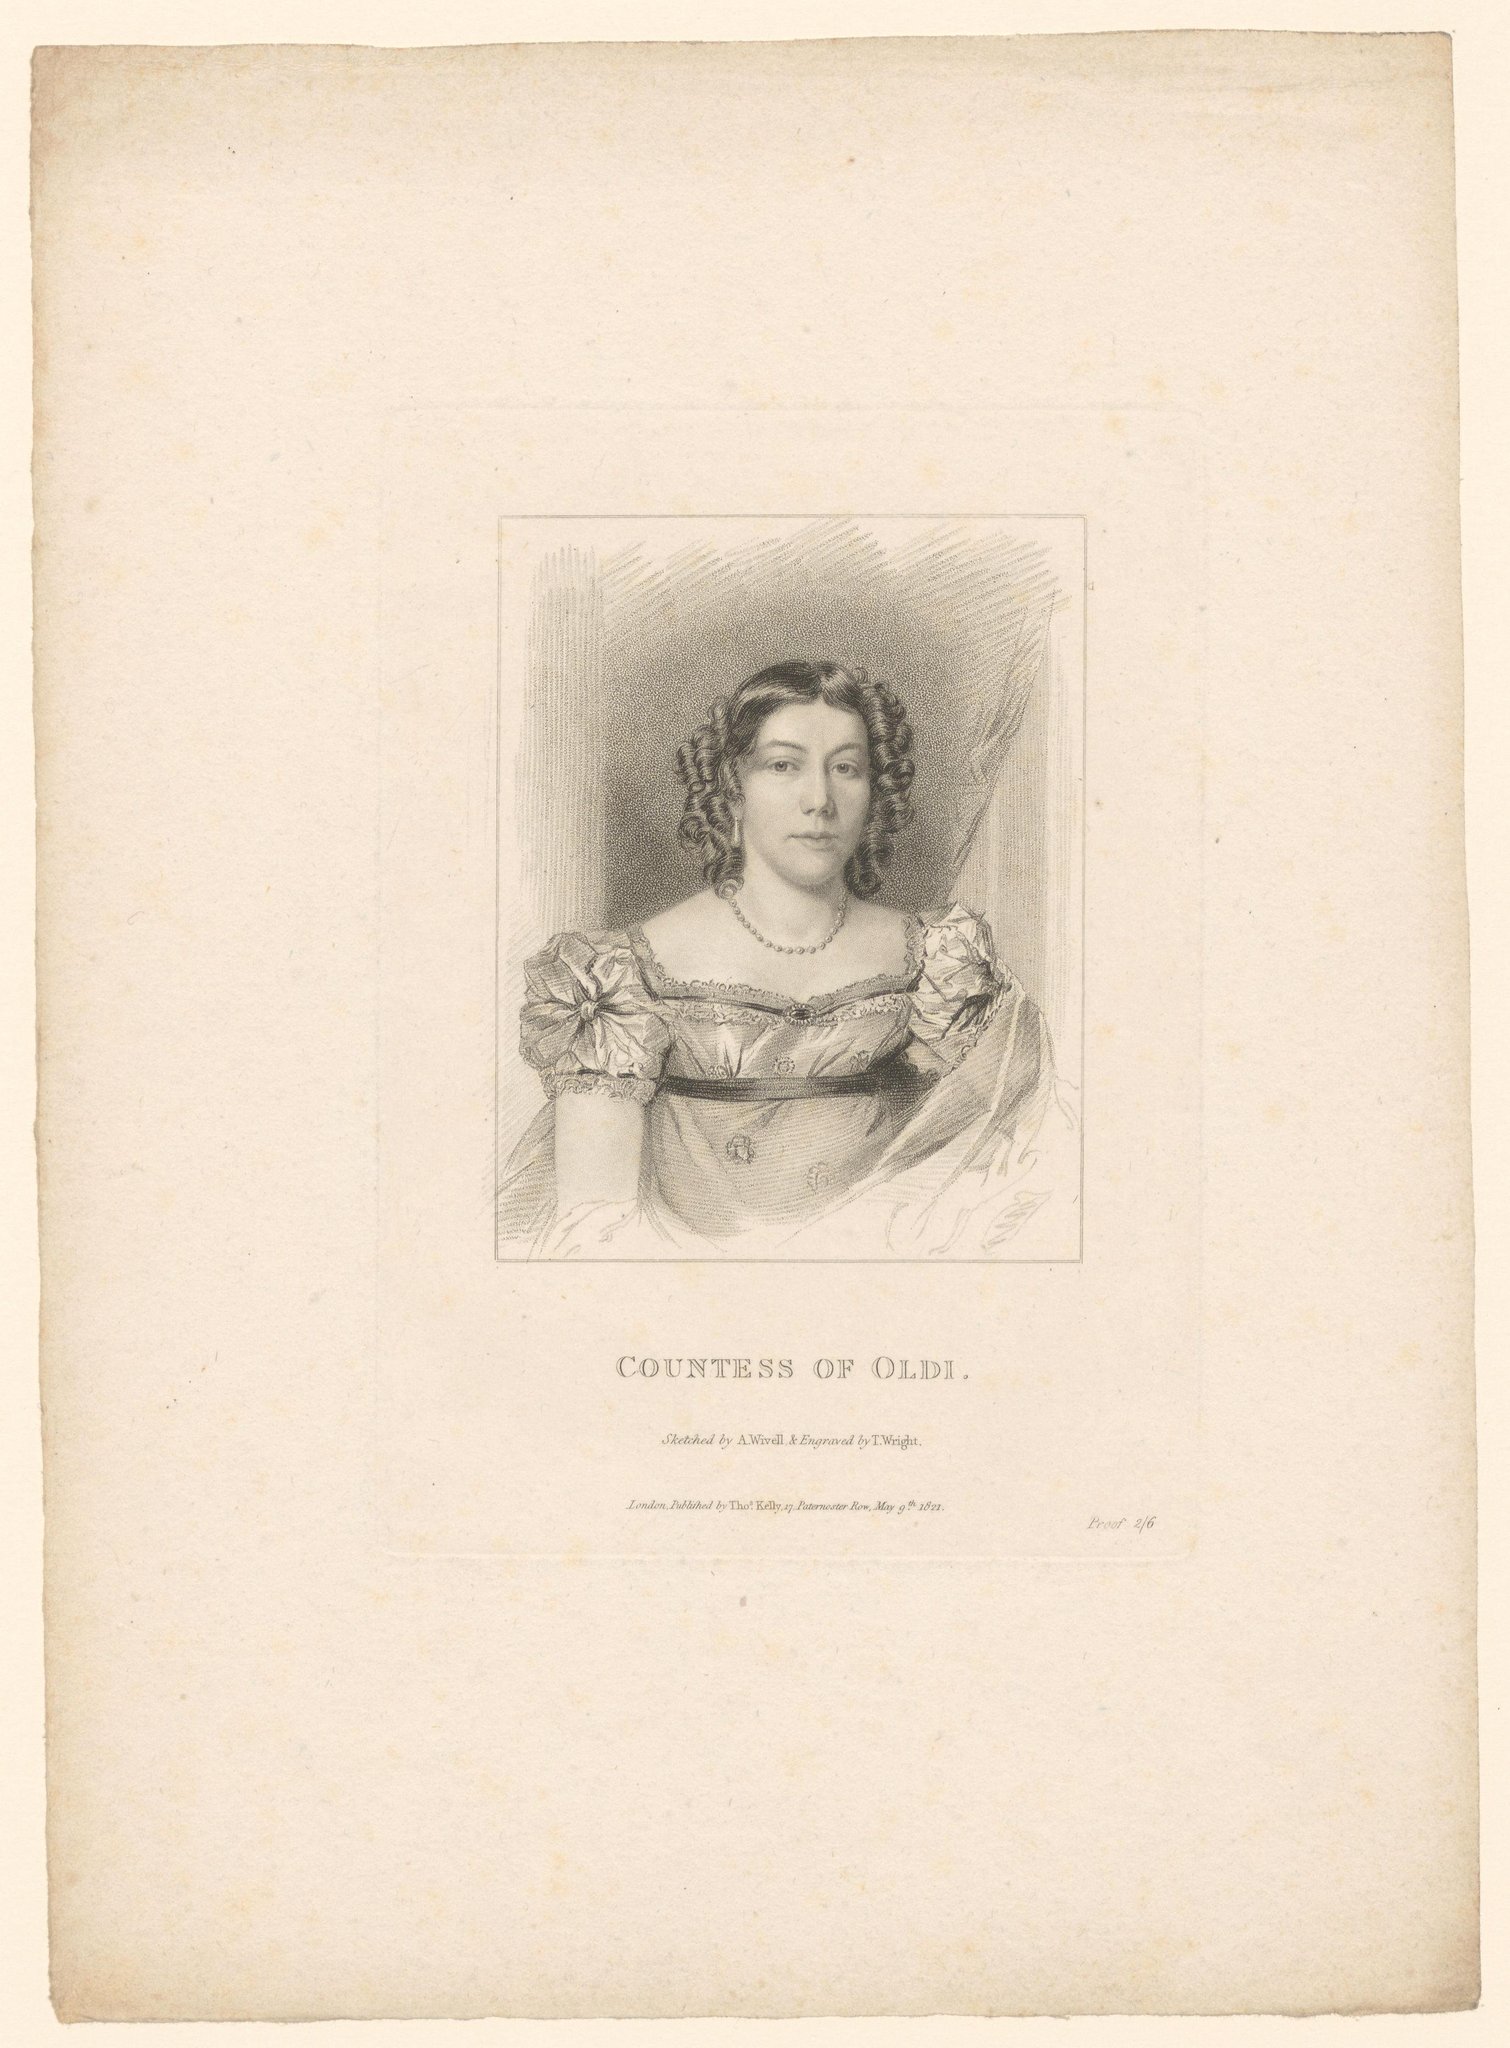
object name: print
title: Countess of Oldi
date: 1821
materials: paper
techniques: etching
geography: london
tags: historical persons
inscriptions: collector's mark: Lugt 2228, number: ‘Proof 2/6’